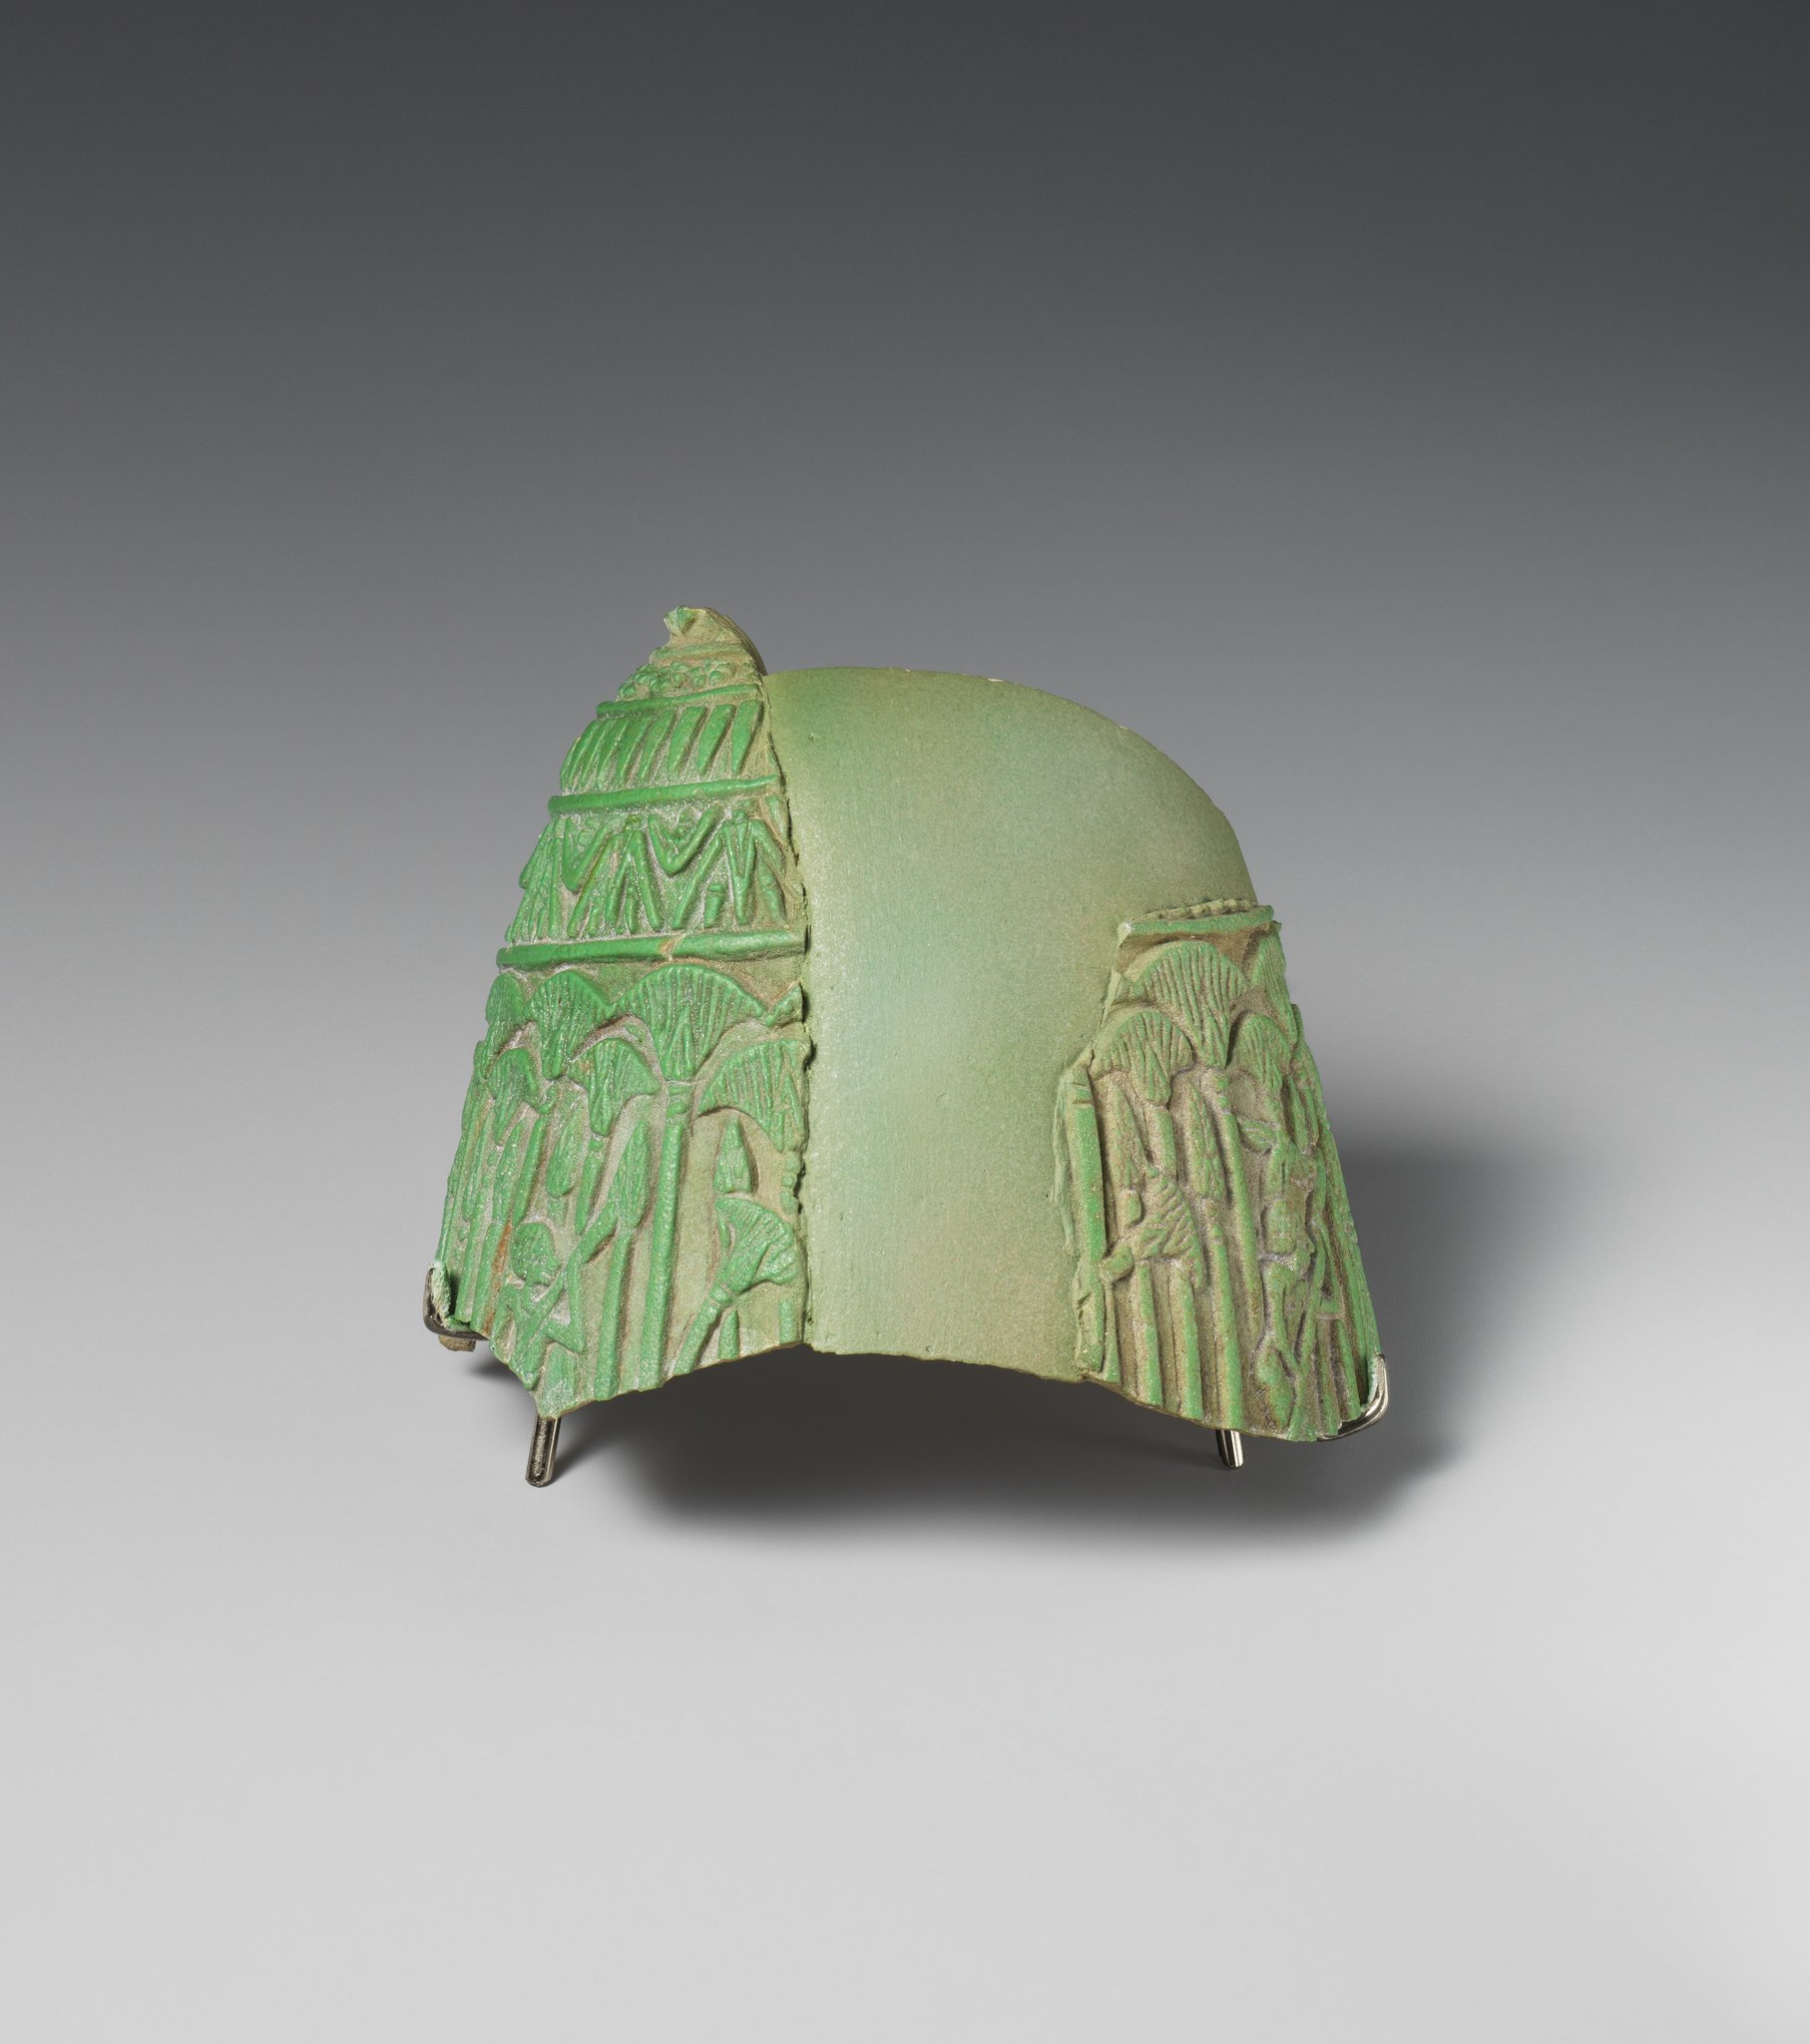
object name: flask fragment, chalice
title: Fragment of ovoid flask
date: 1070-664 BCE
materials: faience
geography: upper egypt; thebes, and other places